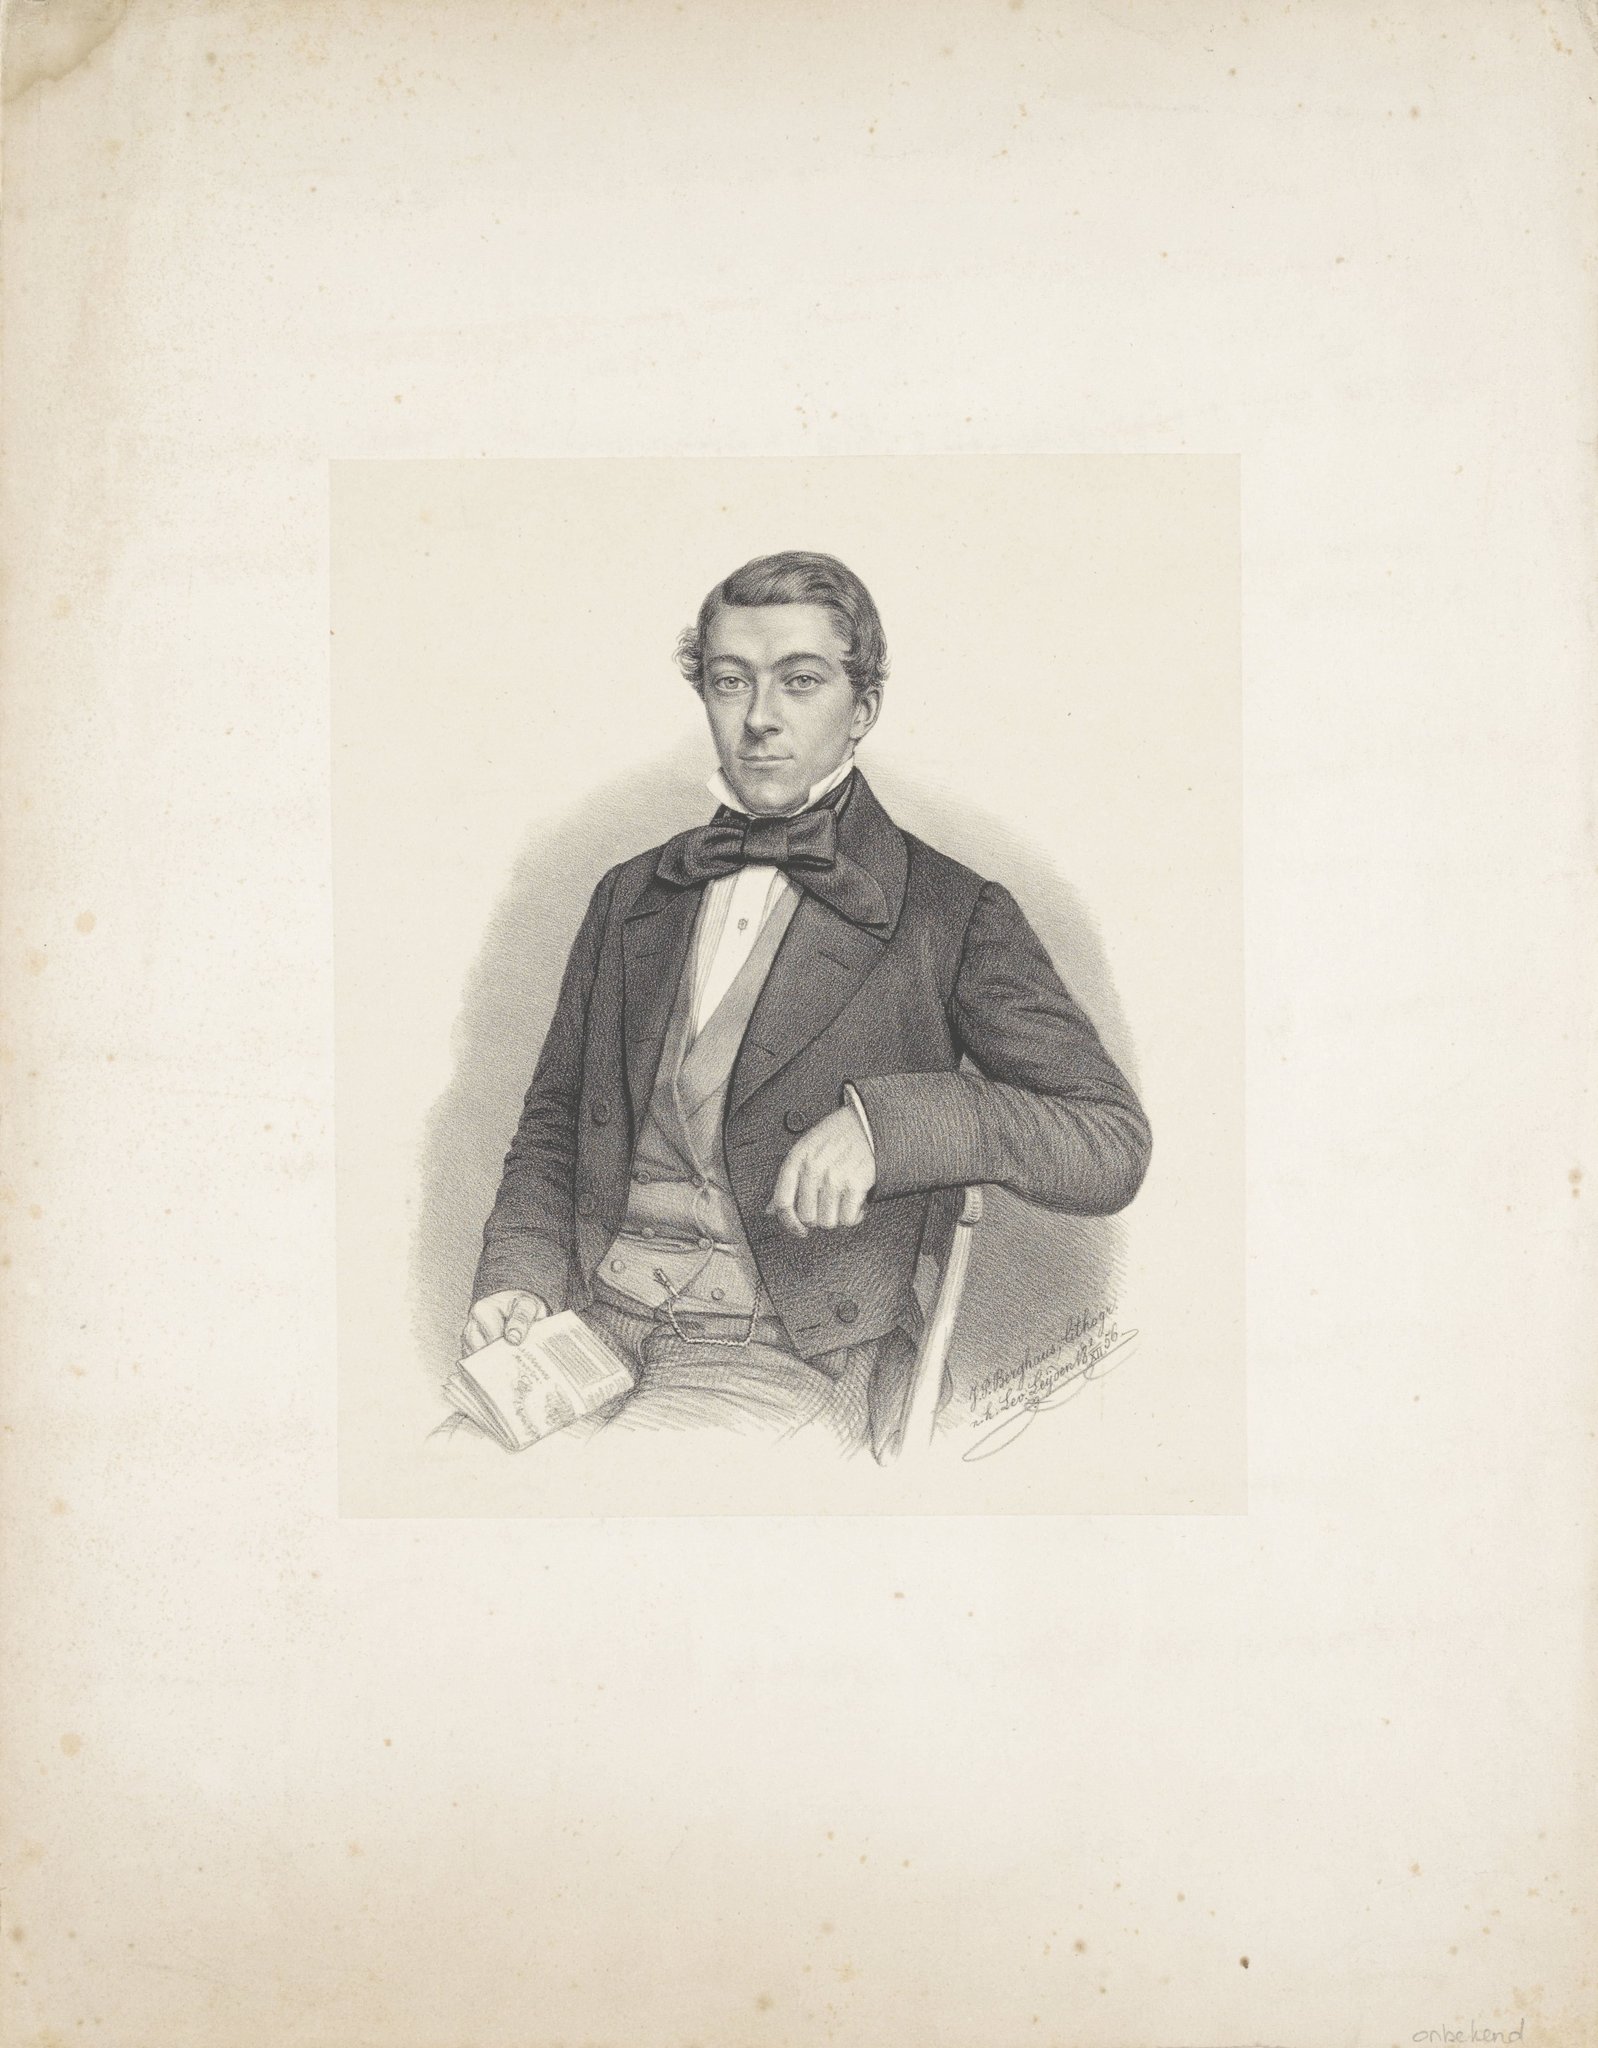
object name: print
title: Portret van een onbekende man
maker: johann peter berghaus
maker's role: print maker, printer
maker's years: 1810-1870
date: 1856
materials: paper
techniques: lithograph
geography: leiden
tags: historical persons, newspaper, news-sheet, watch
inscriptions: collector's mark: Lugt 2228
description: De geportretteerde zit op een stoel en leunt met zijn linkerarm op de rugleuning. In zijn rechterhand heeft hij een krant. Aan zijn vest hangt de ketting van een zakhorloge.